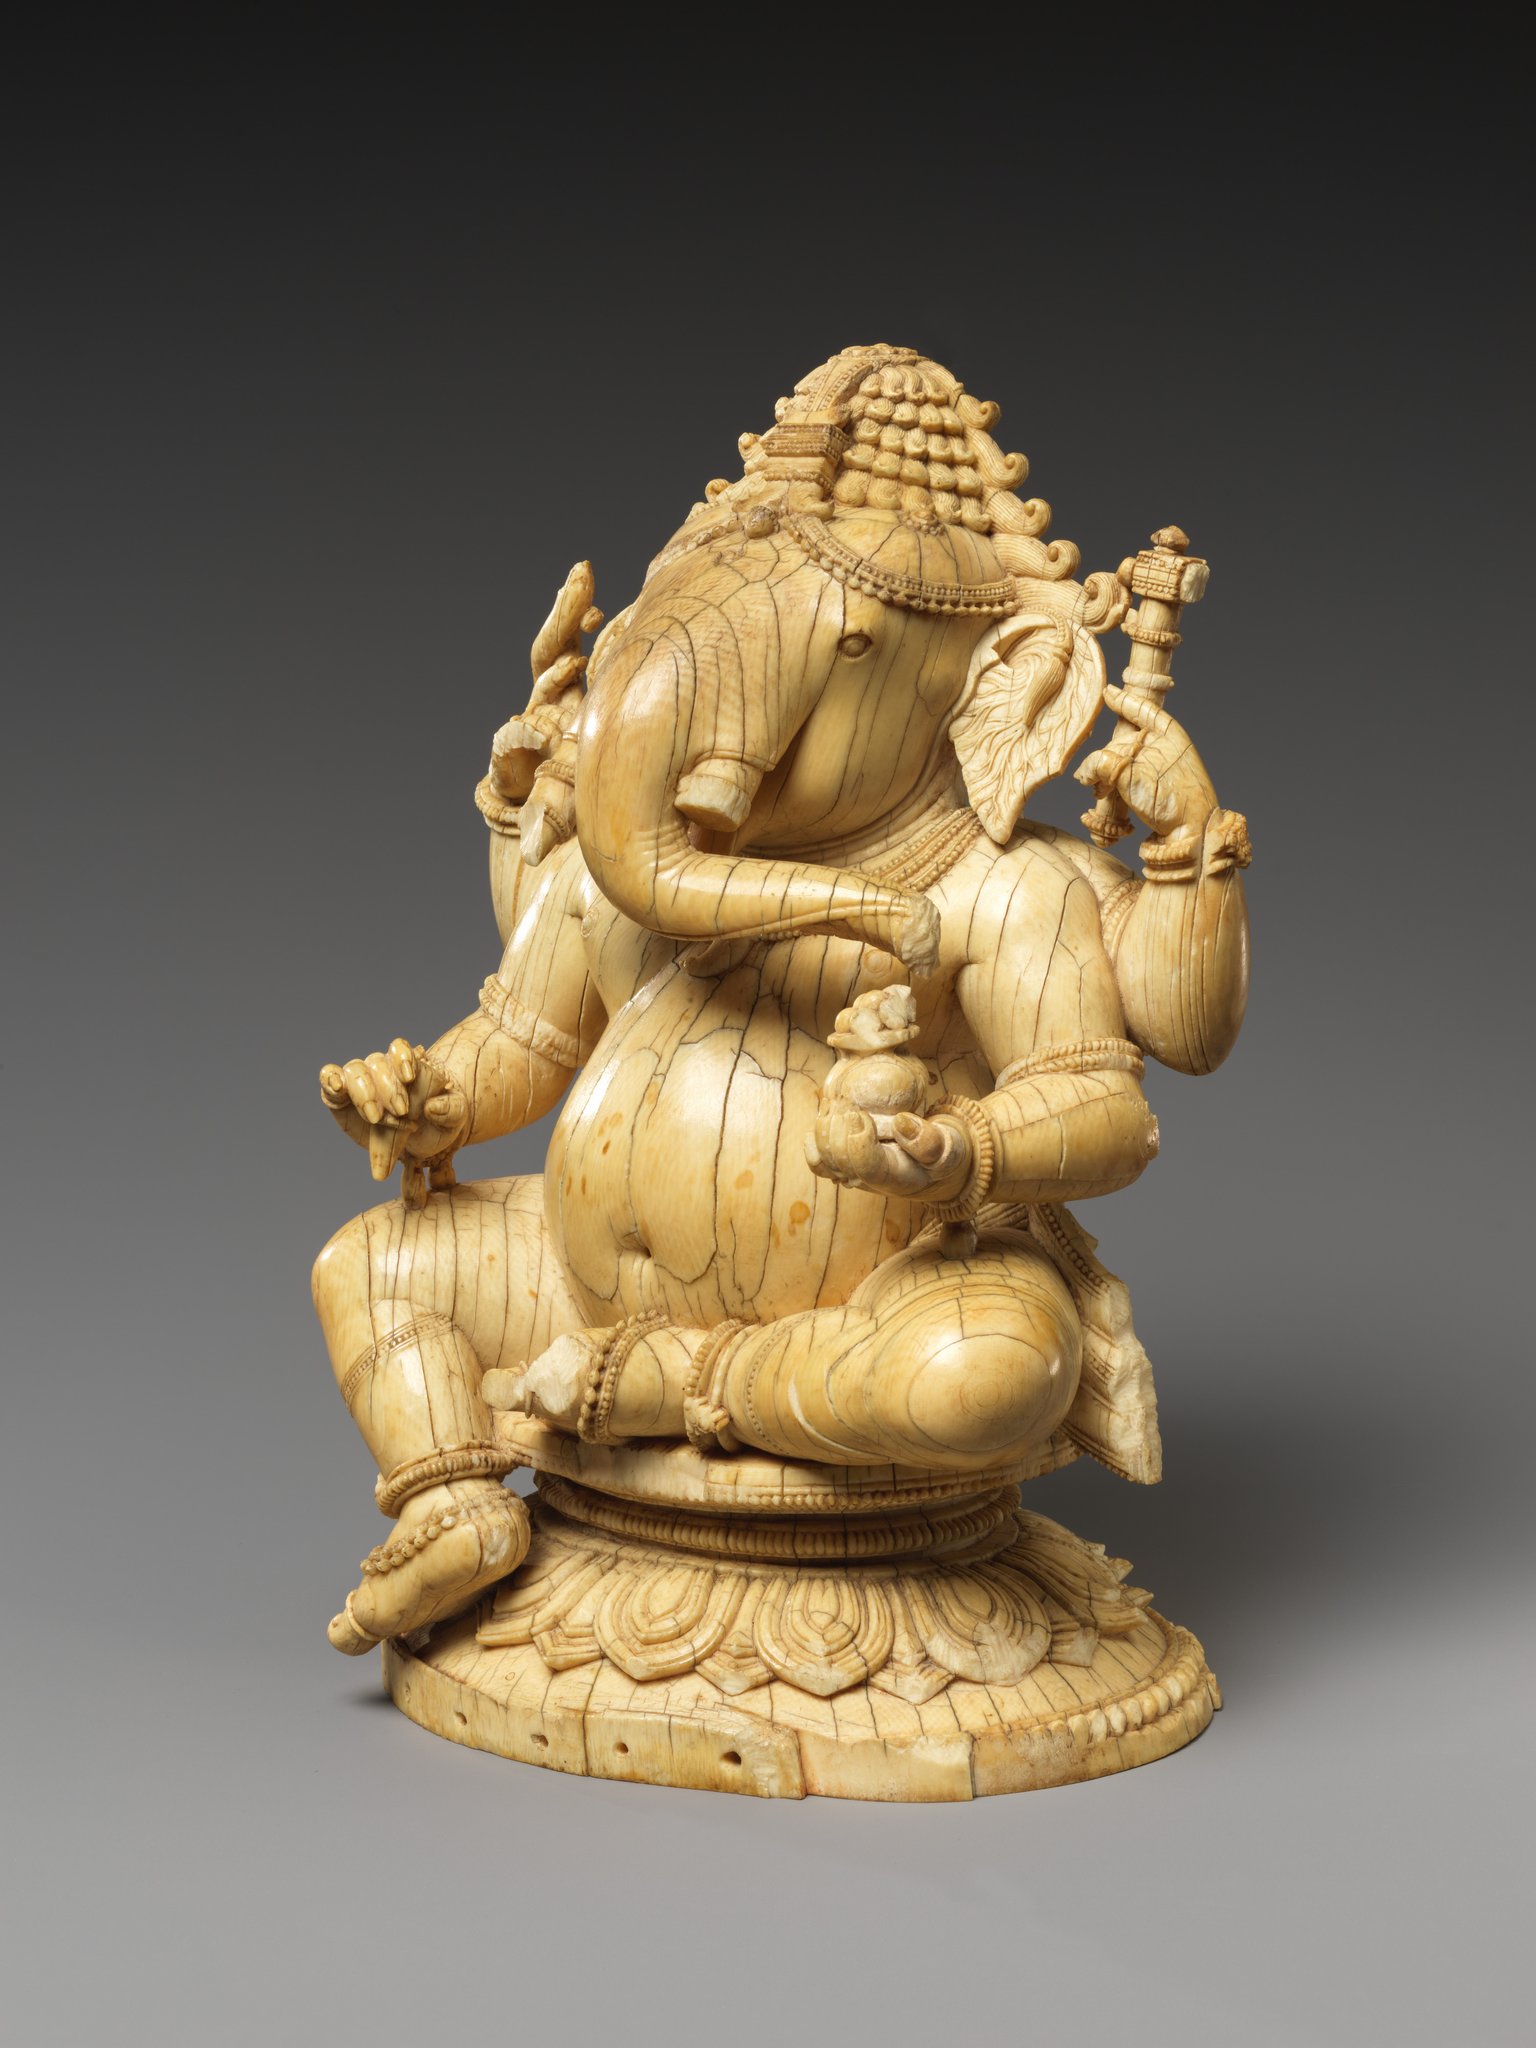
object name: figure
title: Seated Ganesha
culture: indian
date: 1601-1700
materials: ivory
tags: elephants,ganesha